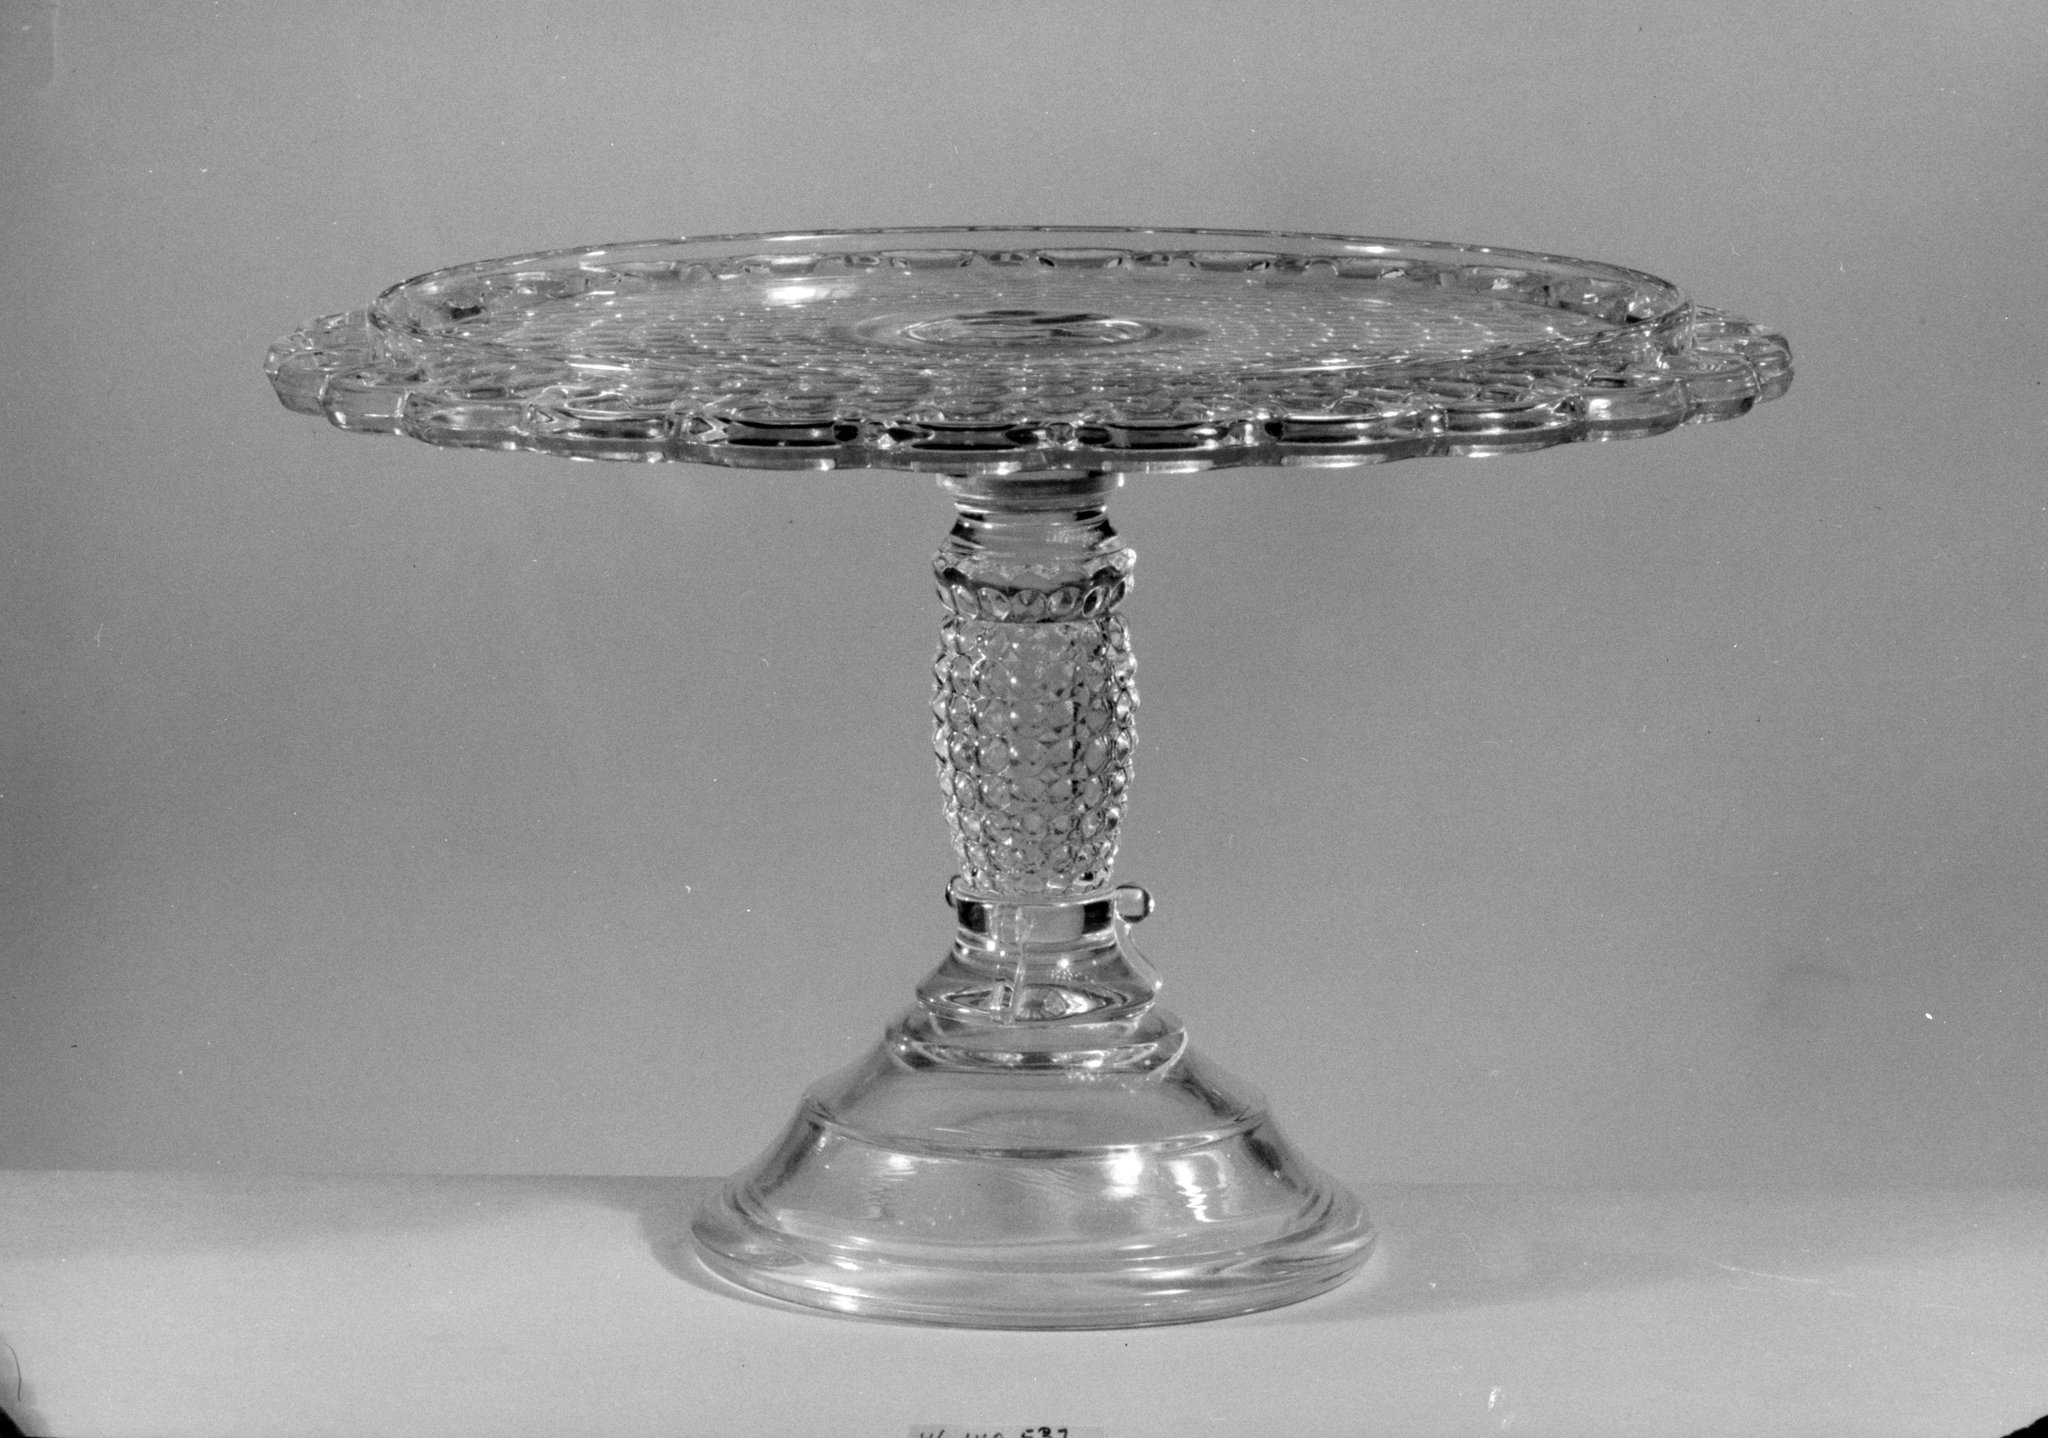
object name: cake plate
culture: american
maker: adams and company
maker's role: maker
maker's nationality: american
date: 1870-1890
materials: glass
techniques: pressed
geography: united states